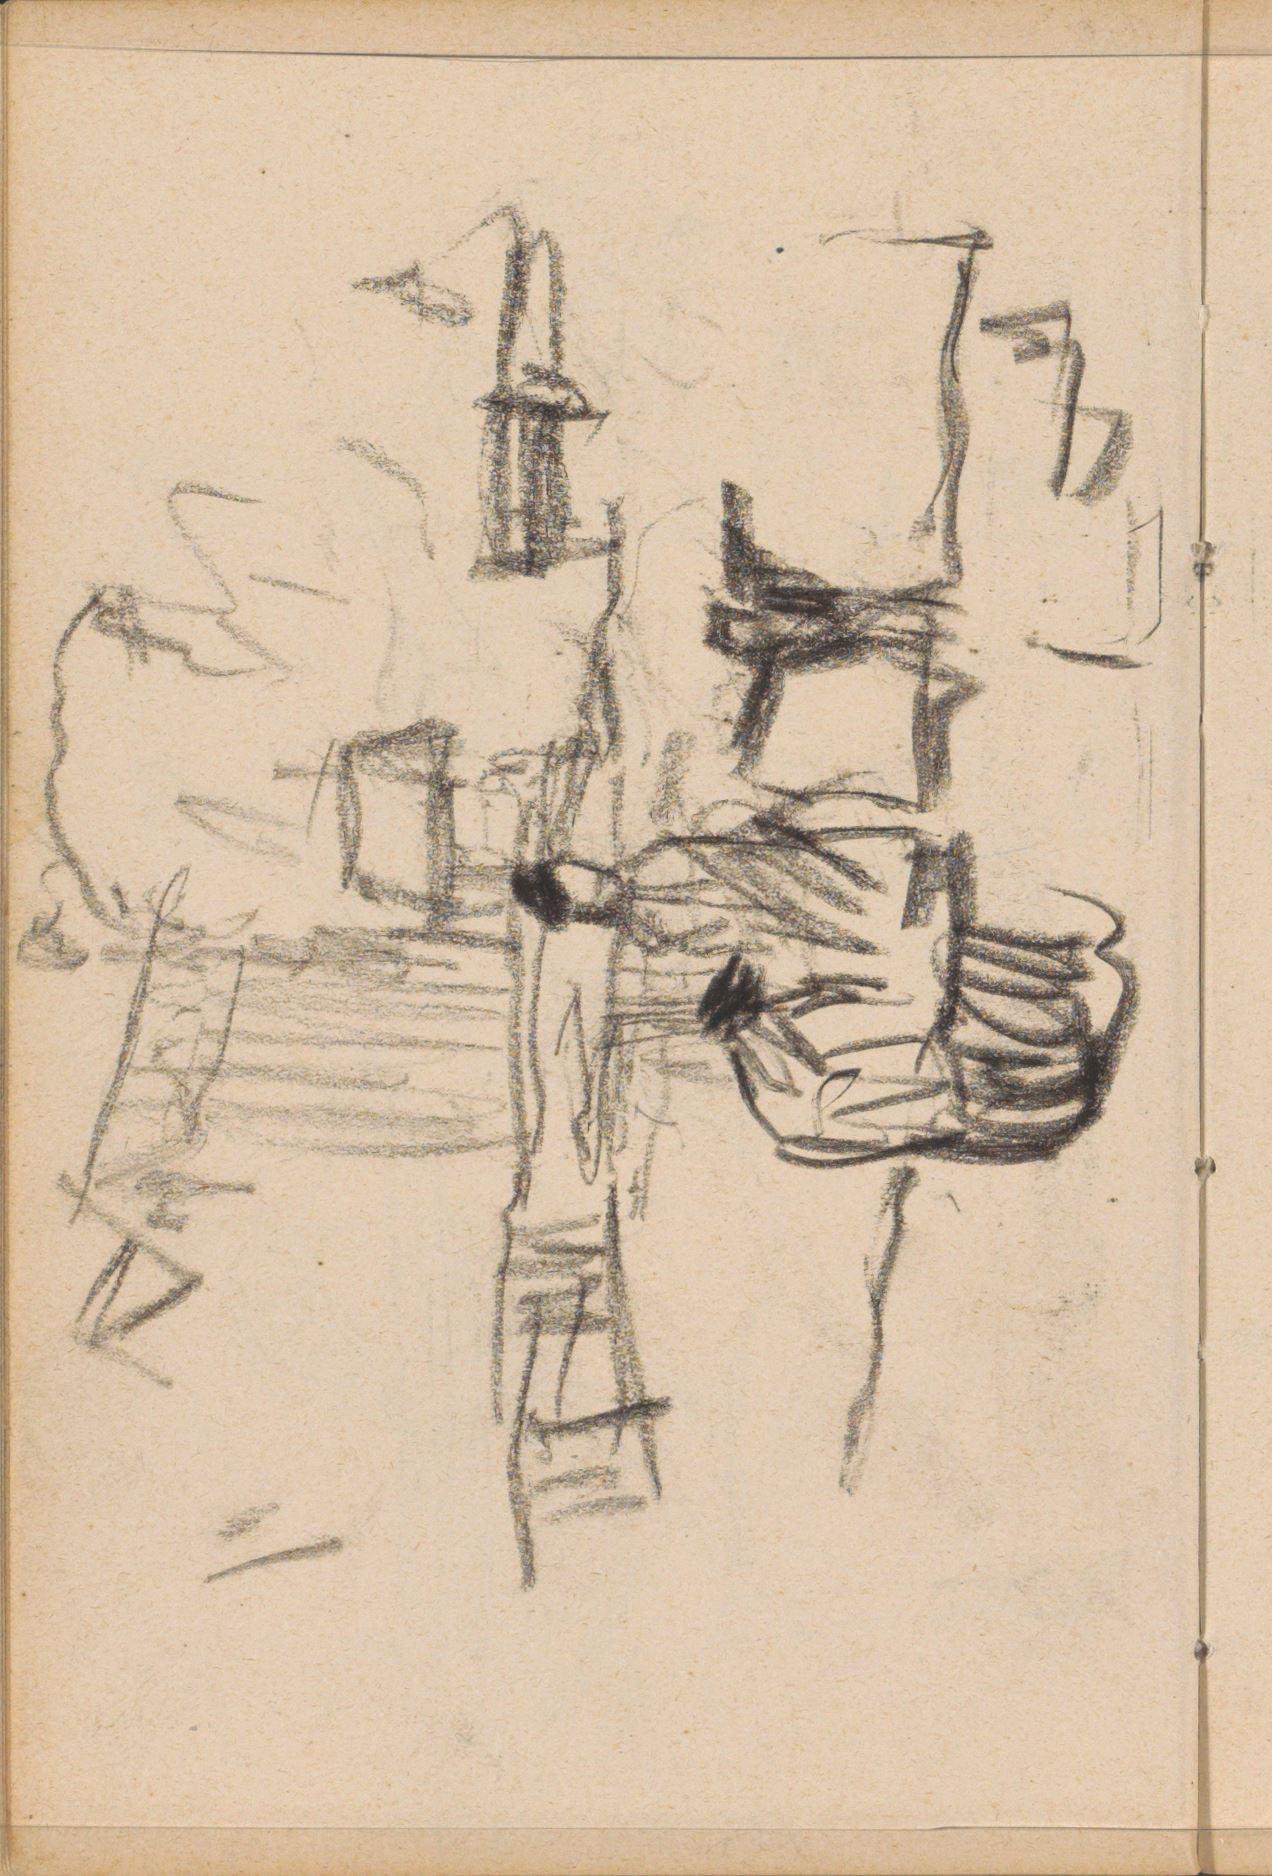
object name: sketchbook leaf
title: Figuren bij een brug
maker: george hendrik breitner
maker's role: draughtsman, painter, print maker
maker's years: 1857-1923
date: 1909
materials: chalk, paper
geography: amsterdam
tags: urban housing, bridge in city across river, canal, etc. (+ city(-scape) with figures, staffage)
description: Figuren bij een brug. Op de achtergrond gebouwen. Pagina 29 uit een schetsboek met 45 bladen vervaardigd in Amsterdam en Pittsburgh.